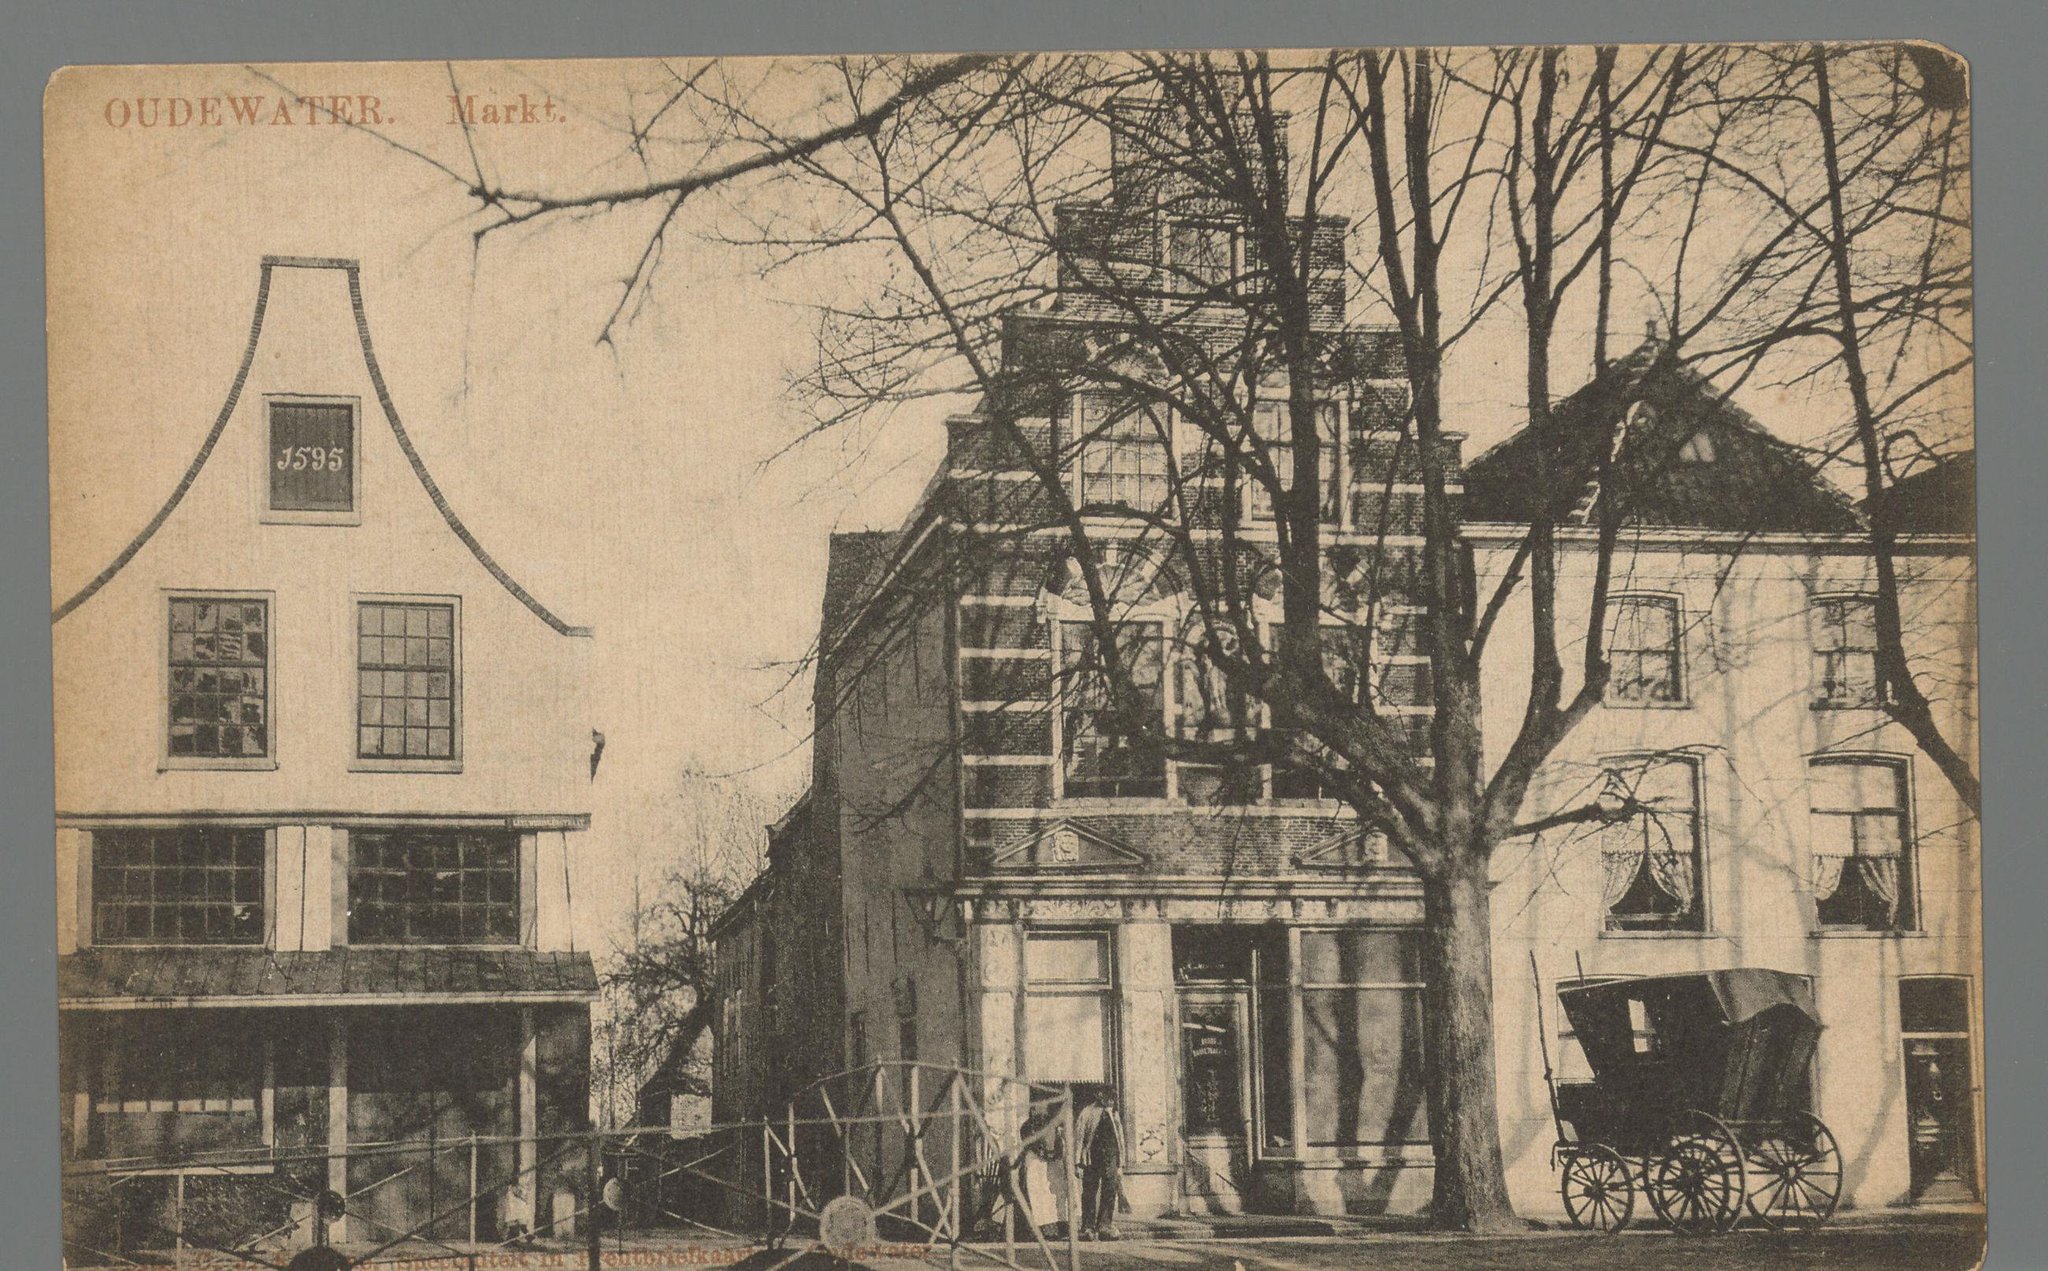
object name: photomechanical print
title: Oudewater. Markt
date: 1905-1919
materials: cardboard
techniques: photograph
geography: oudewater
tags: square, place, circus, etc., street